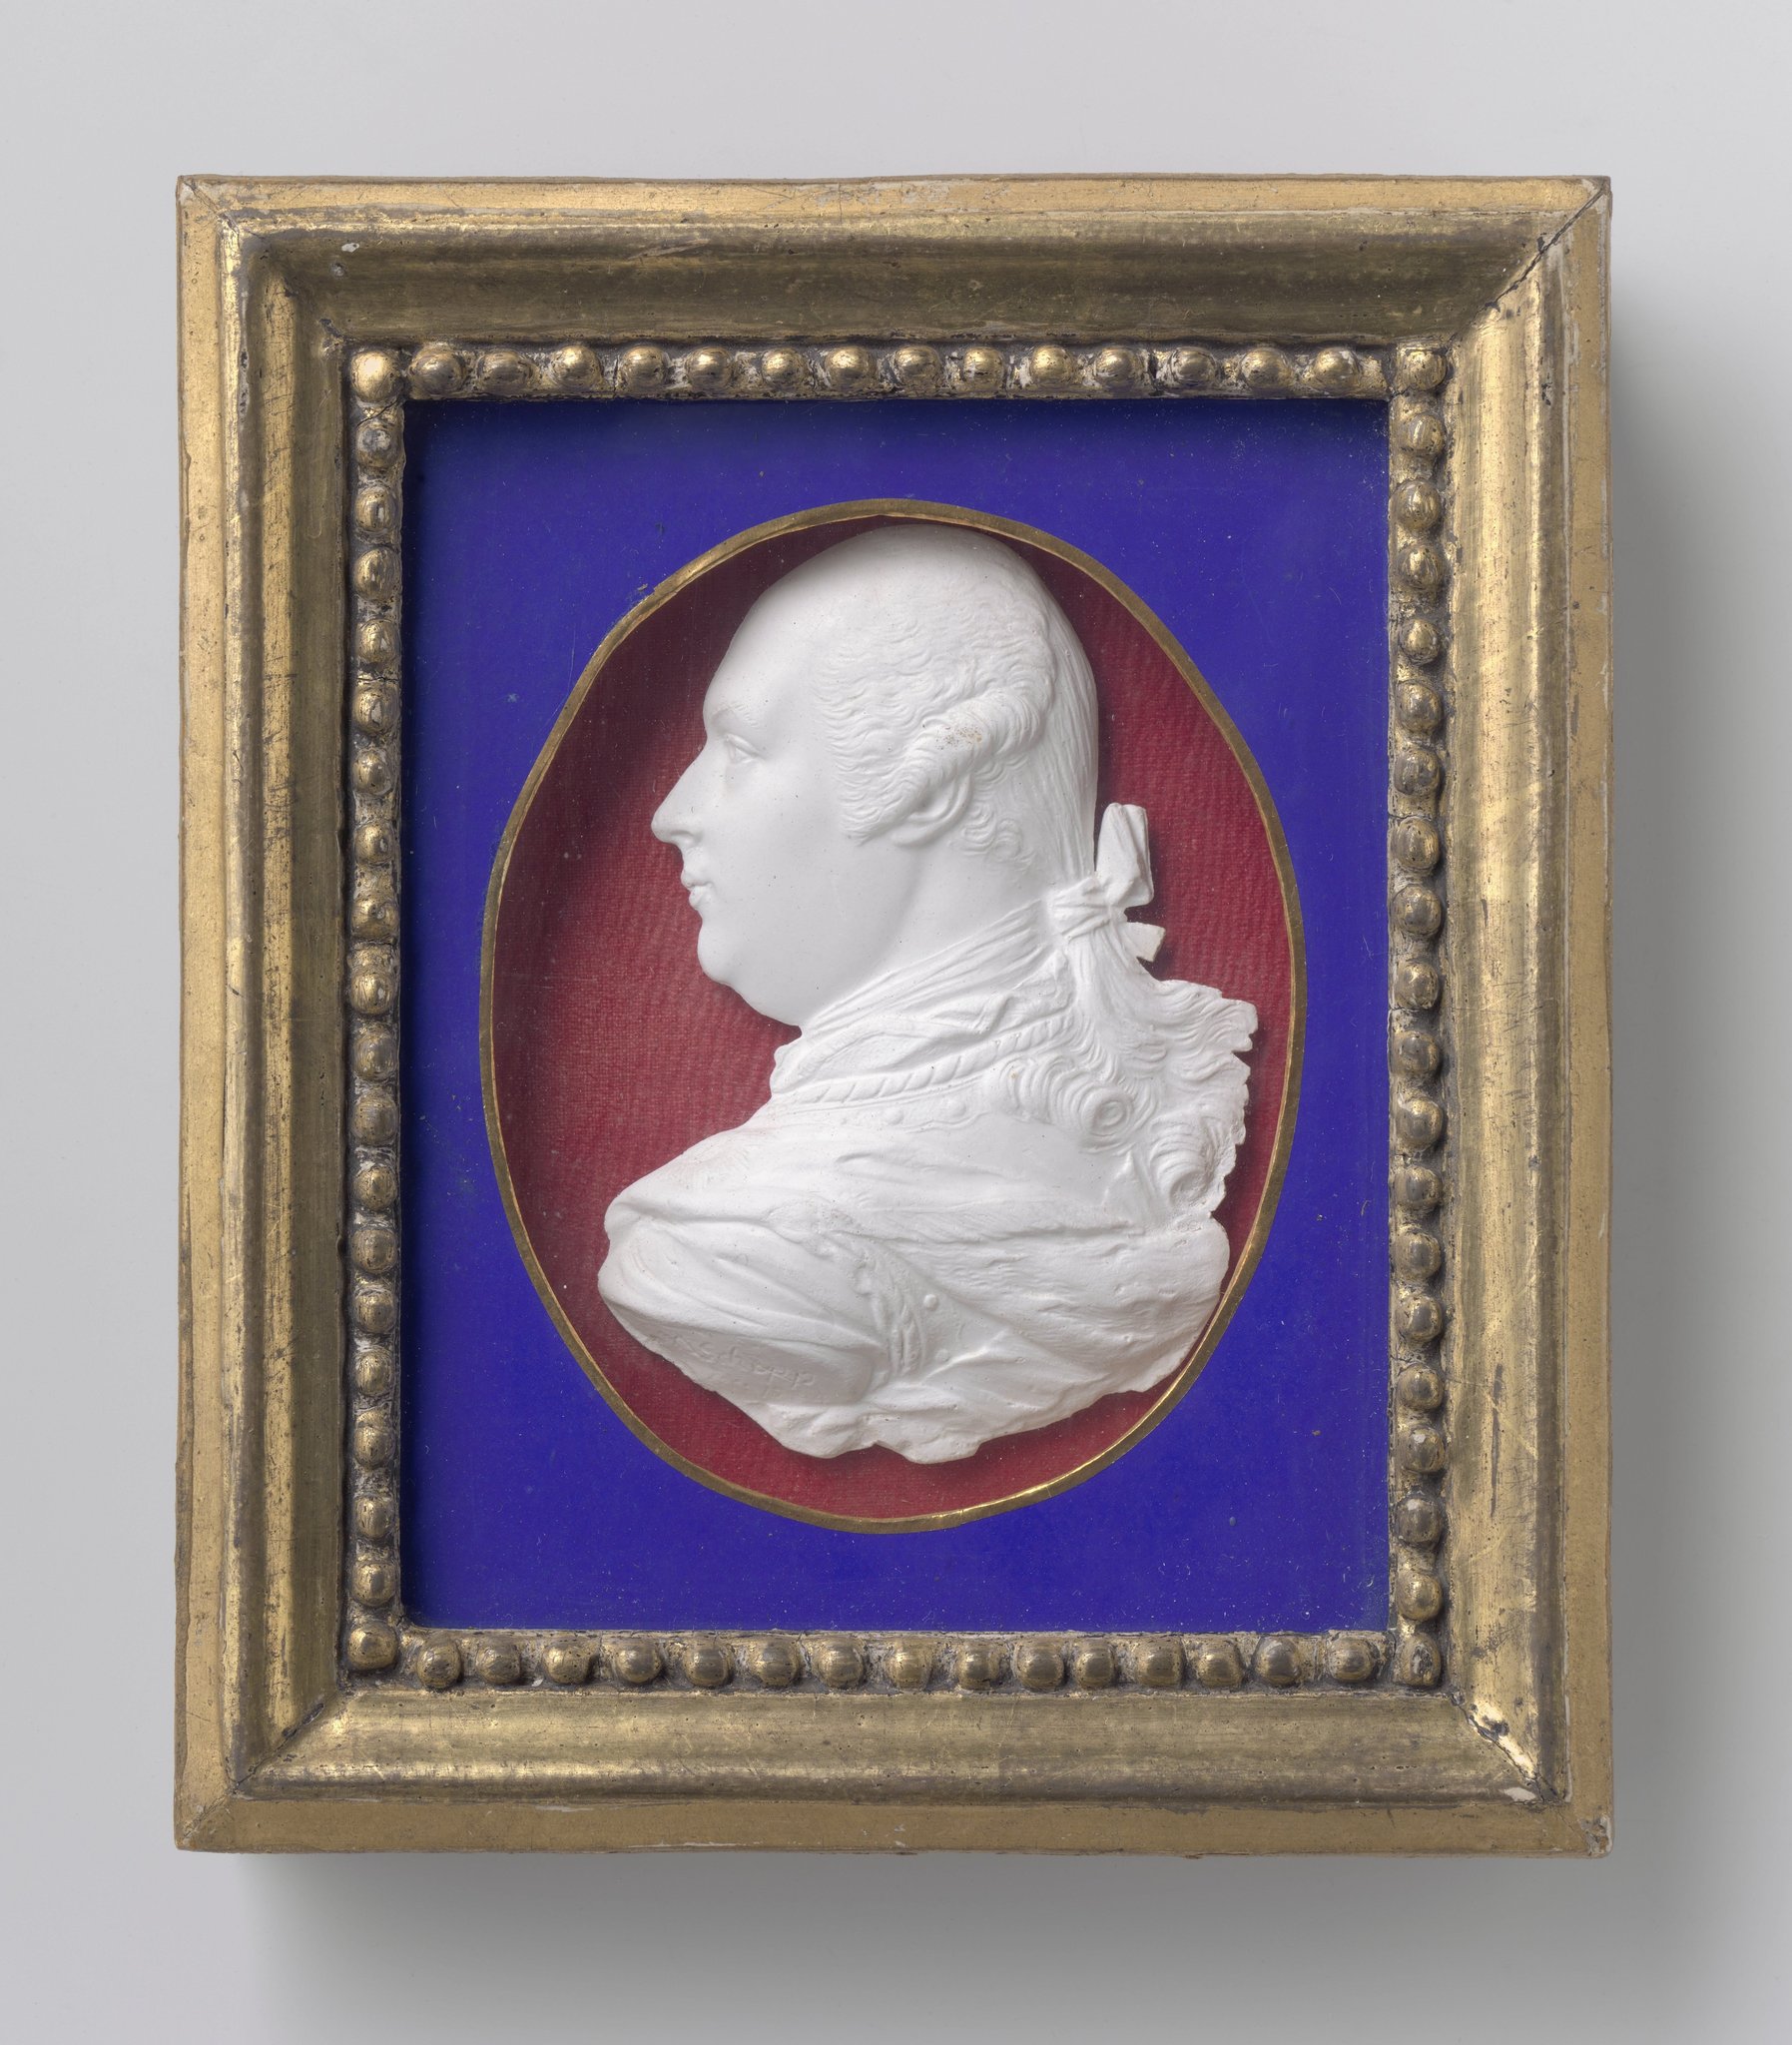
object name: portretmedaillon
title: Portretmedaillon van Frederik II, de Grote, Koning van Pruisen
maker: johann heinrich schepp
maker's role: sculptor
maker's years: 1736-1811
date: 1784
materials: gypsum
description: Portretmedaillon van Frederik II, Koning van Pruisen. Frederik, naar links, draagt een tricorne, staartpruik en rok, waarop een orde.